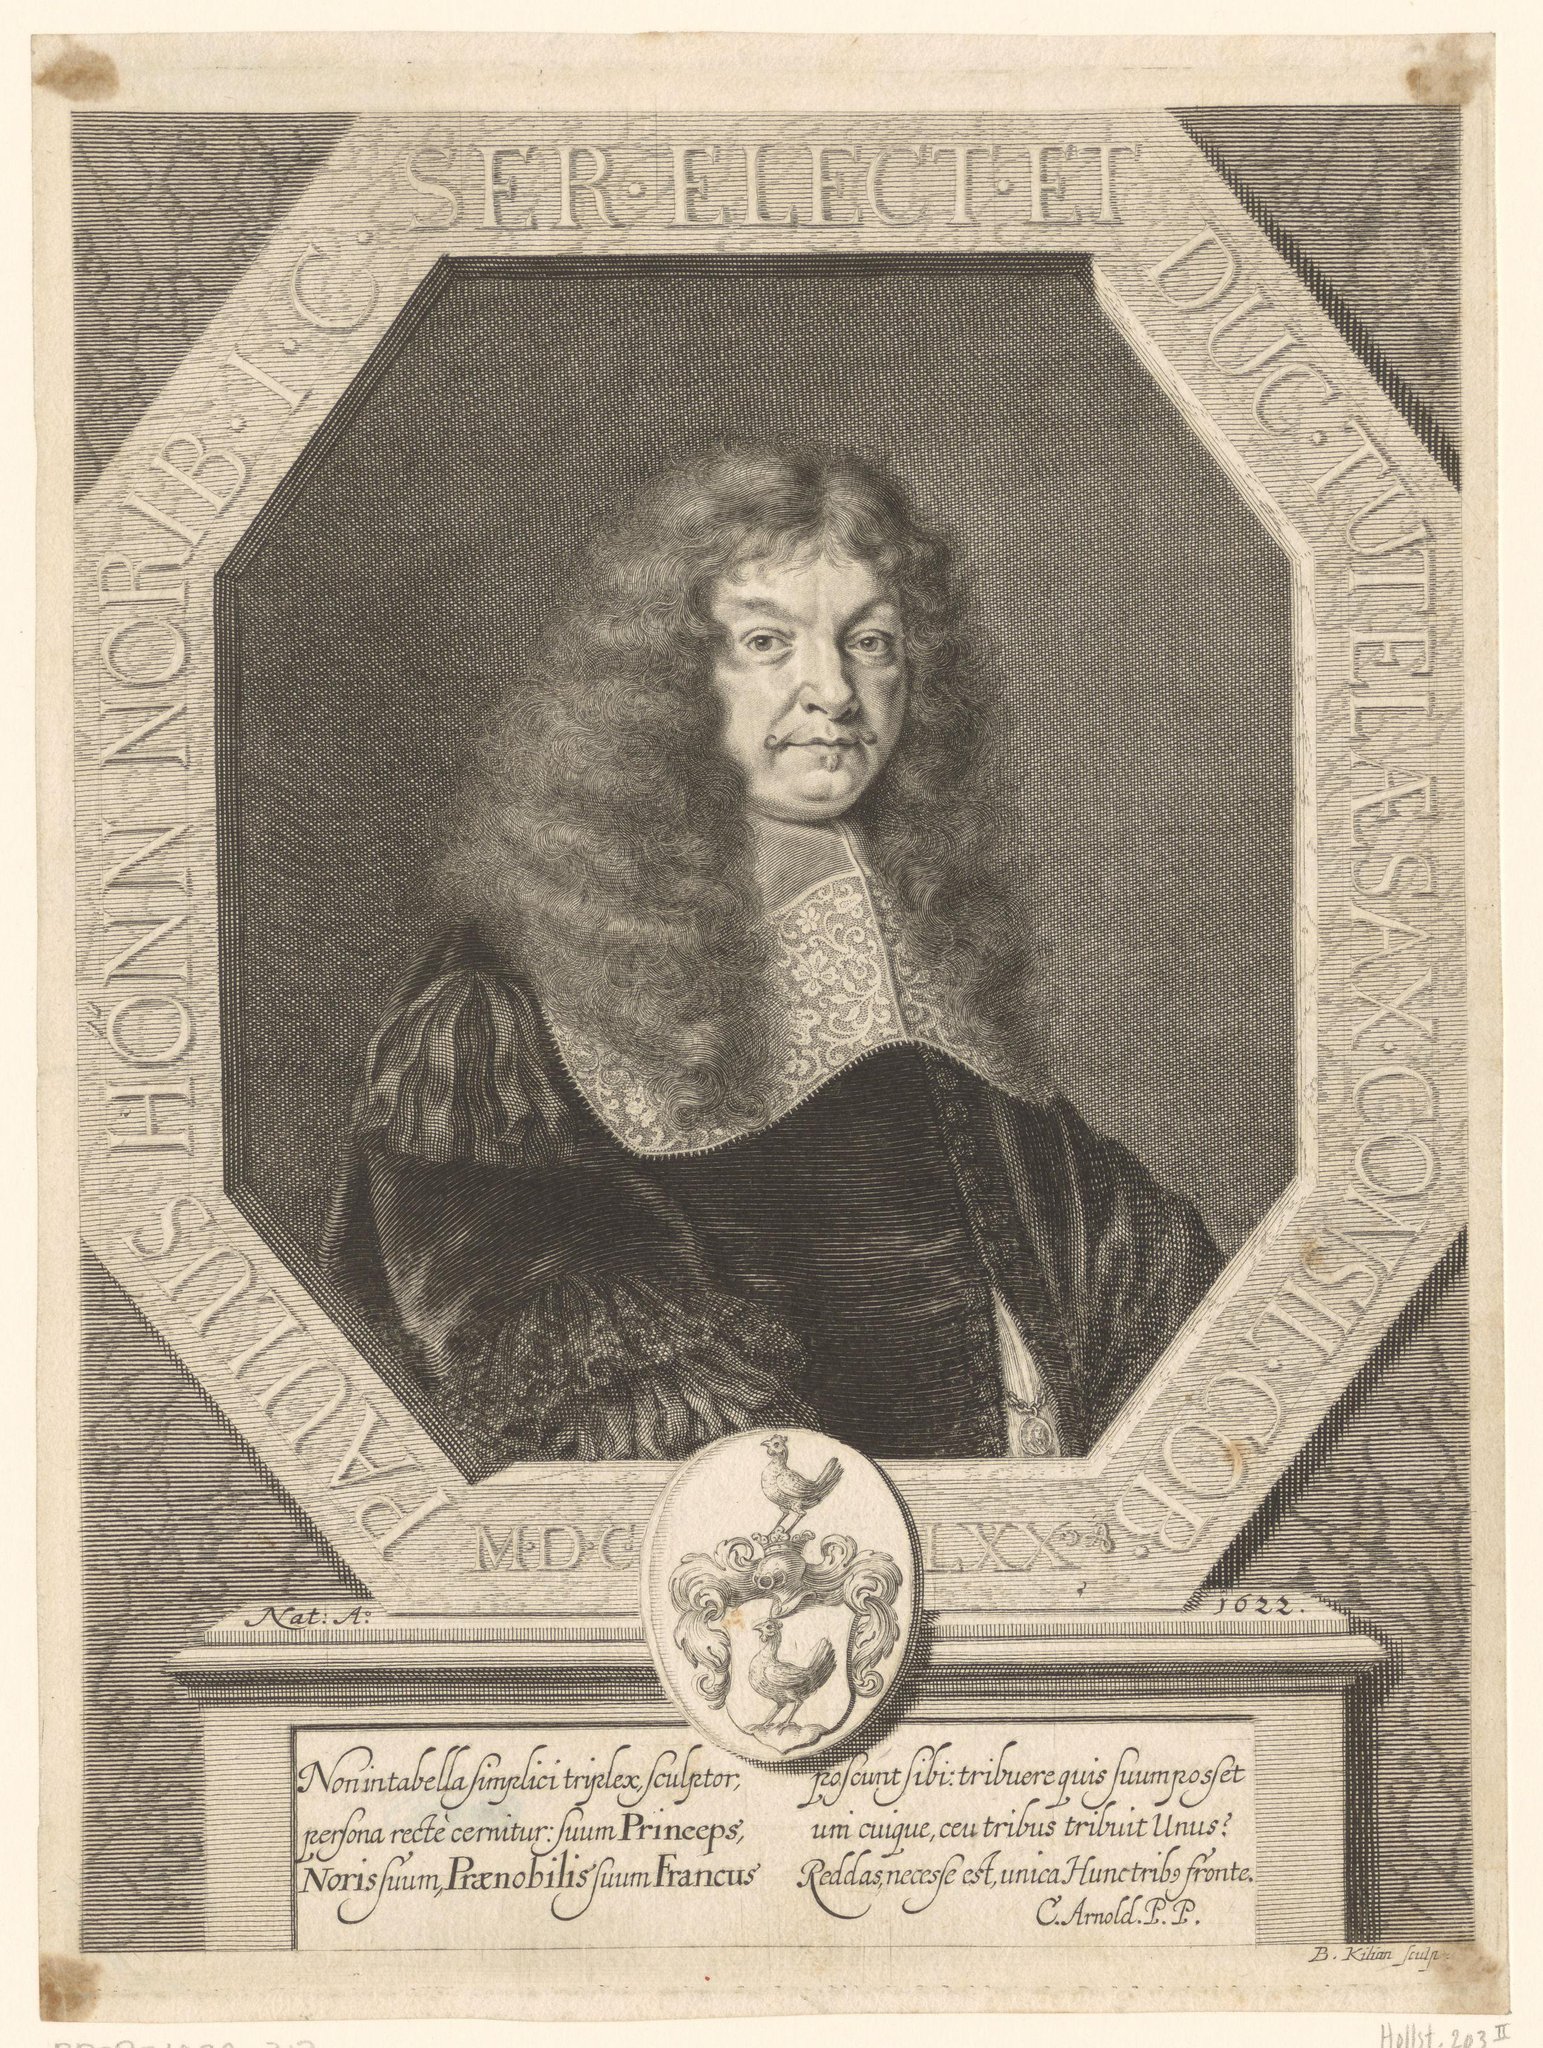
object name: print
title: Portret van Paul Hönn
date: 1670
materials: paper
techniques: engraving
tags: paul hönn, historical persons, lawyer, attorney at law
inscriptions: collector's mark: Lugt 2228